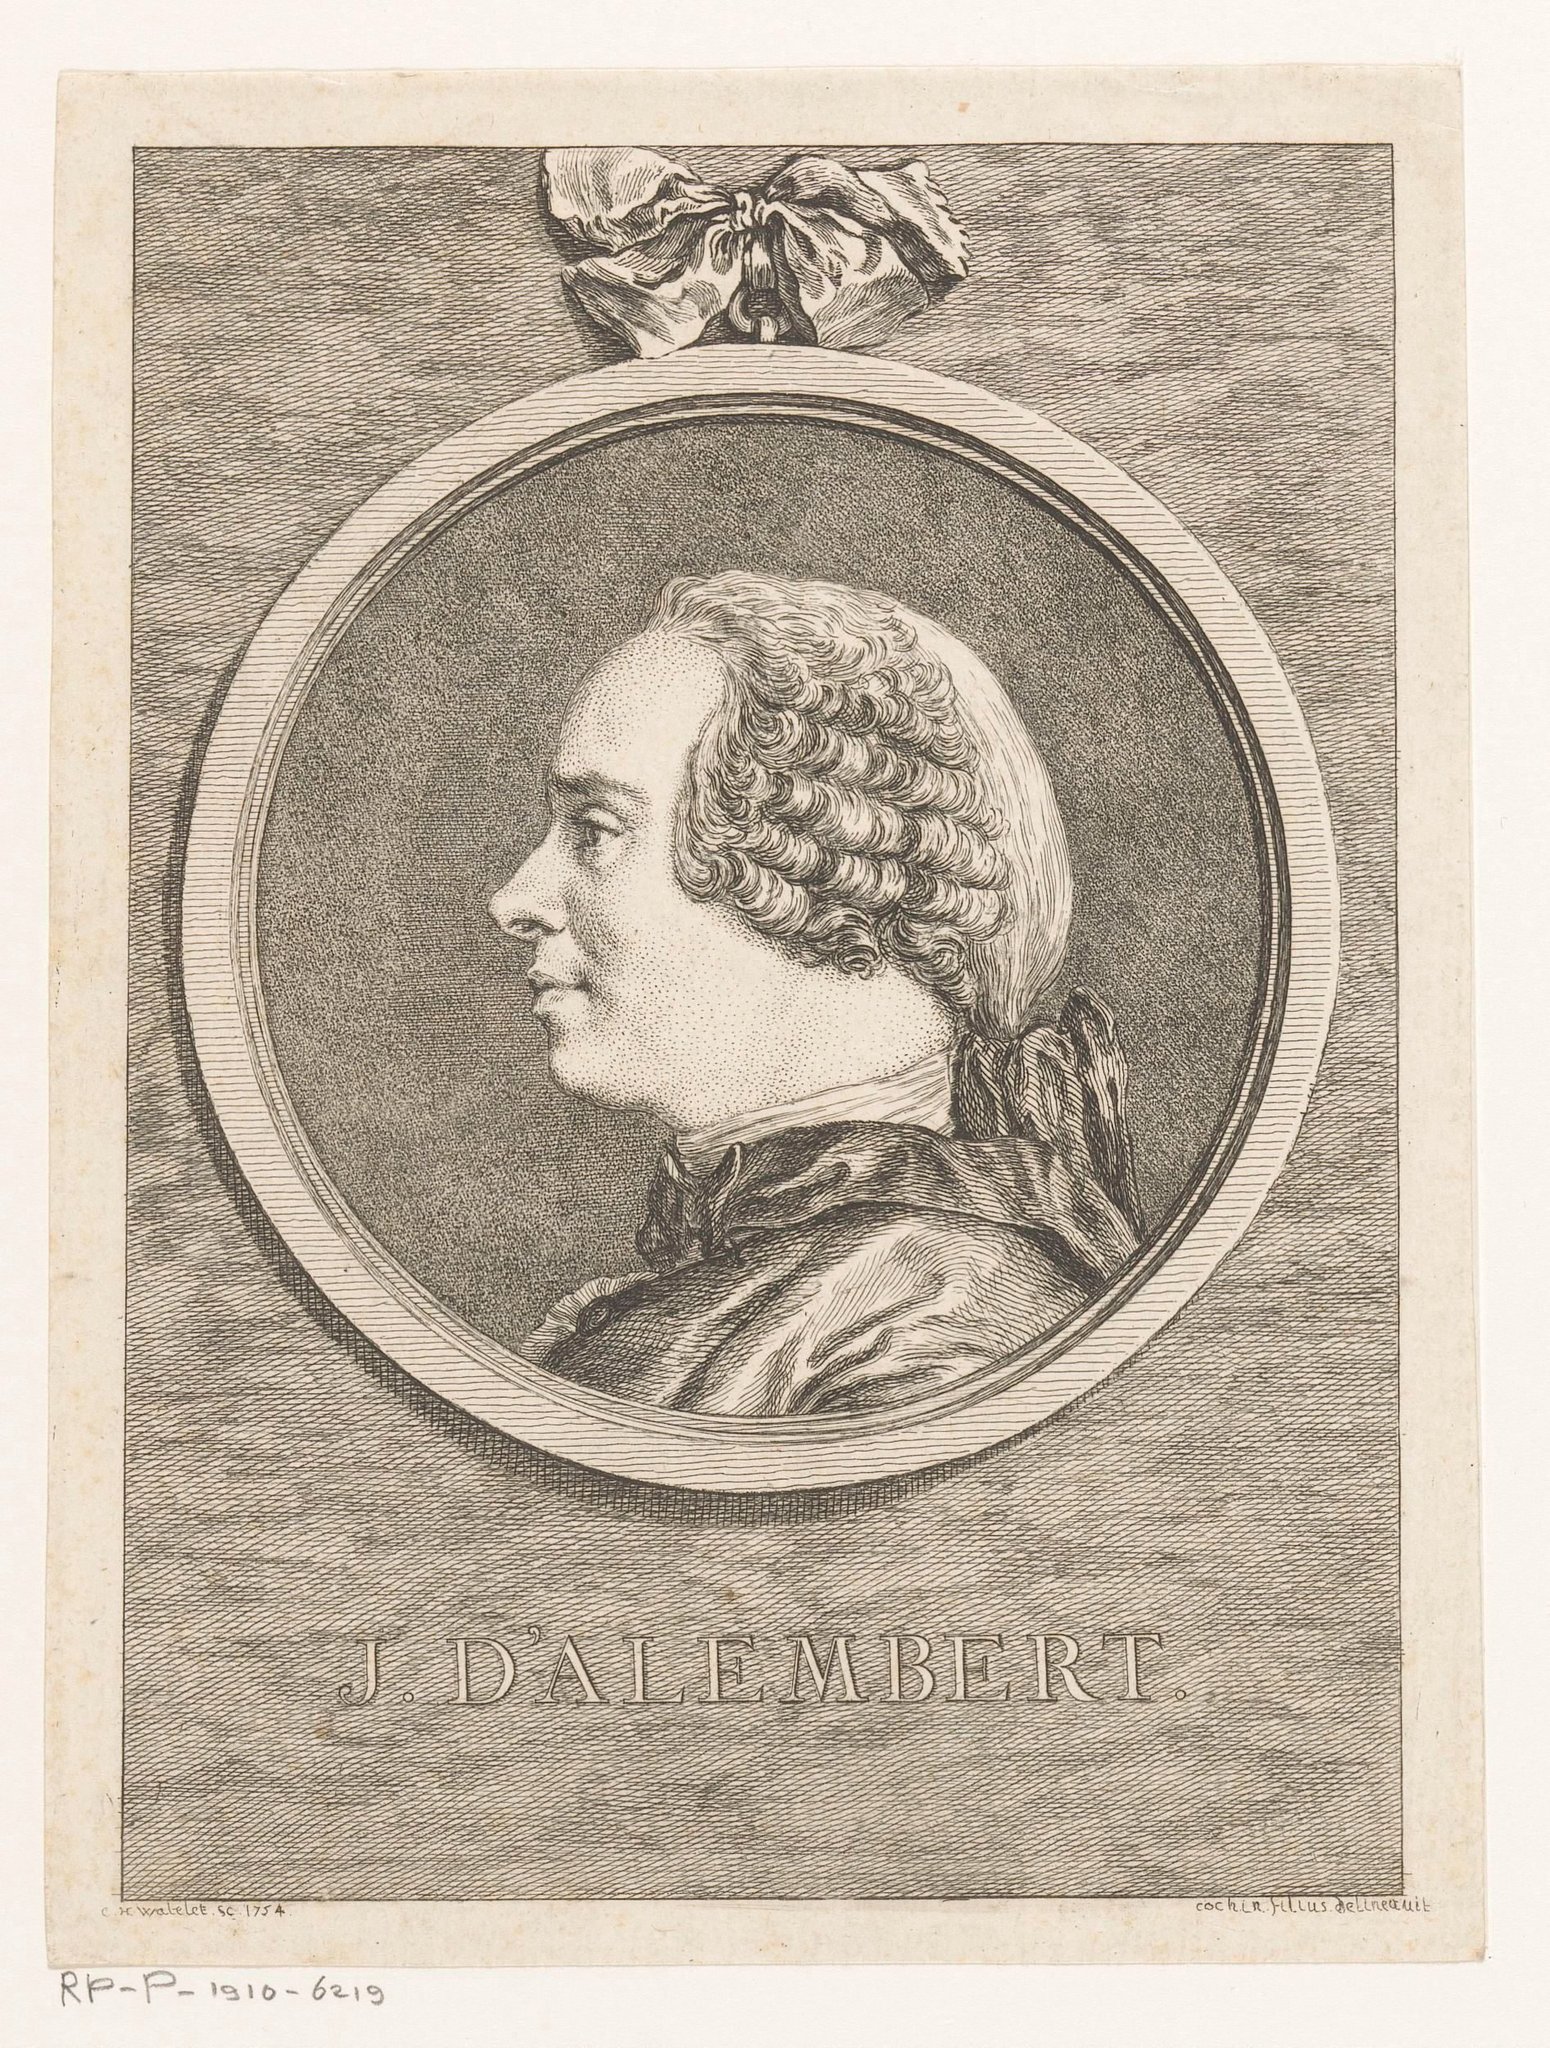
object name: print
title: Portret van Jean Le Rond d'Alembert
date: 1754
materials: paper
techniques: etching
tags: paris, historical persons, adult man (+ sideview, profile)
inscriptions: collector's mark: Lugt 2228